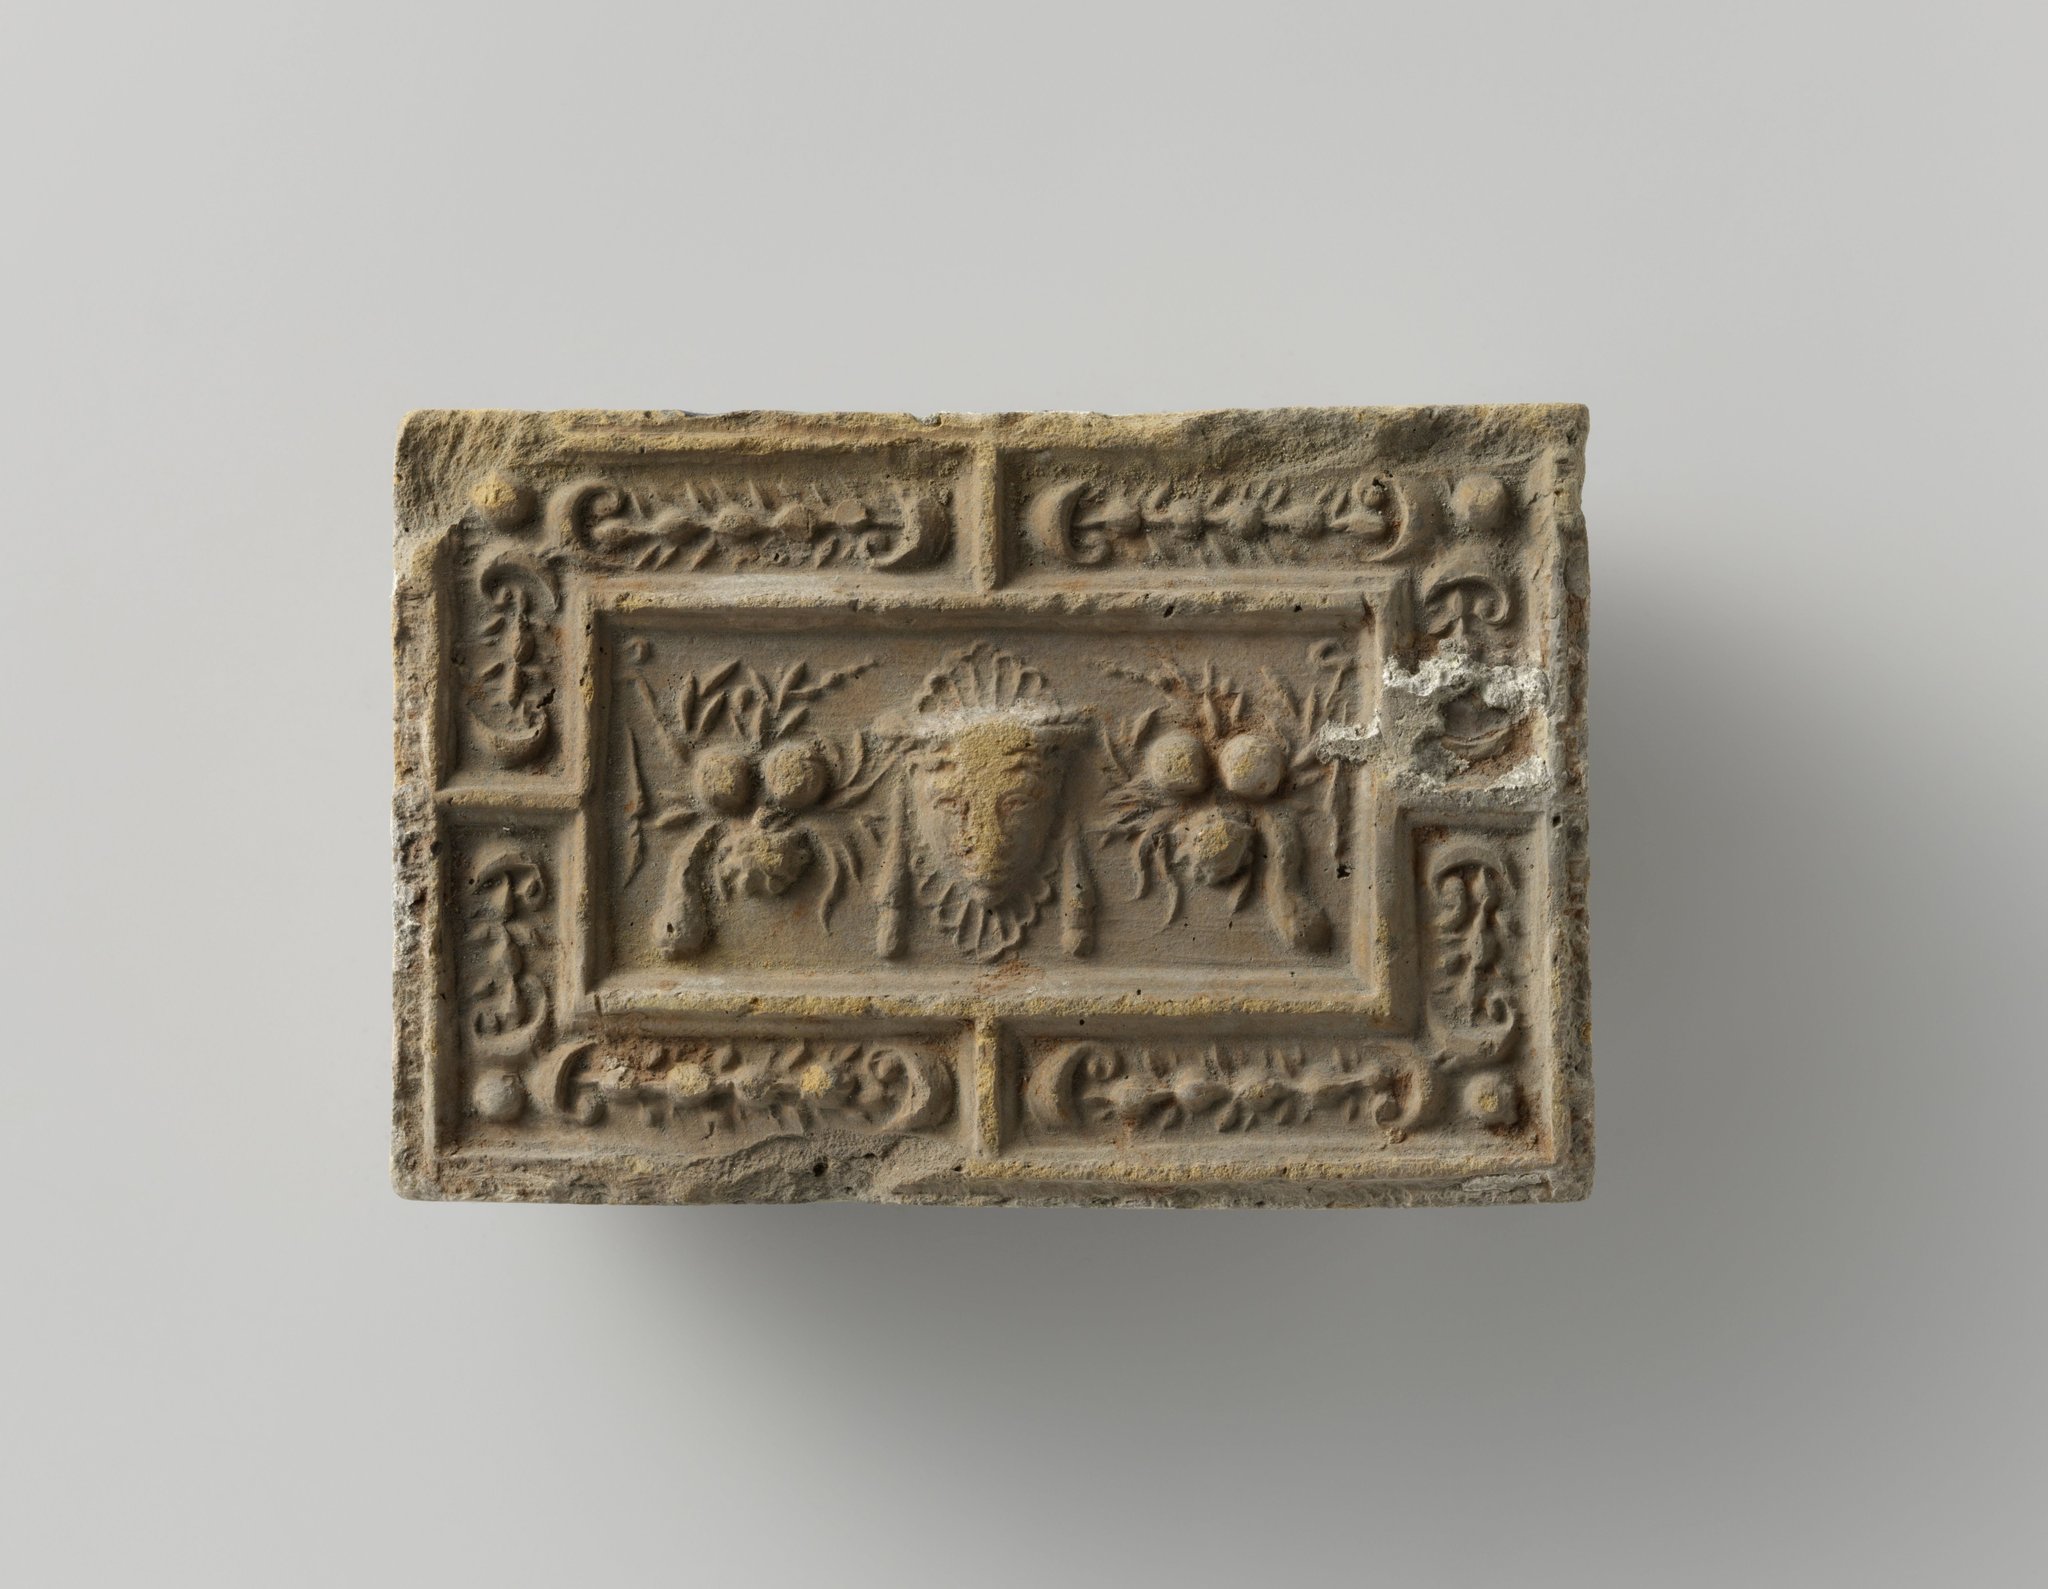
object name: hearthstone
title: Haardsteen met voorstelling van een mascaron tussen twee vruchtfestoenen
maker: Anonymous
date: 1575-1600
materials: earthenware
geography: antwerp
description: Haardsteen van gebakken aarde, met een langwerpig vierkante cartouche waarin een mascaron en guirlanden van vruchten en daaromheen een doorlopende guirlande.